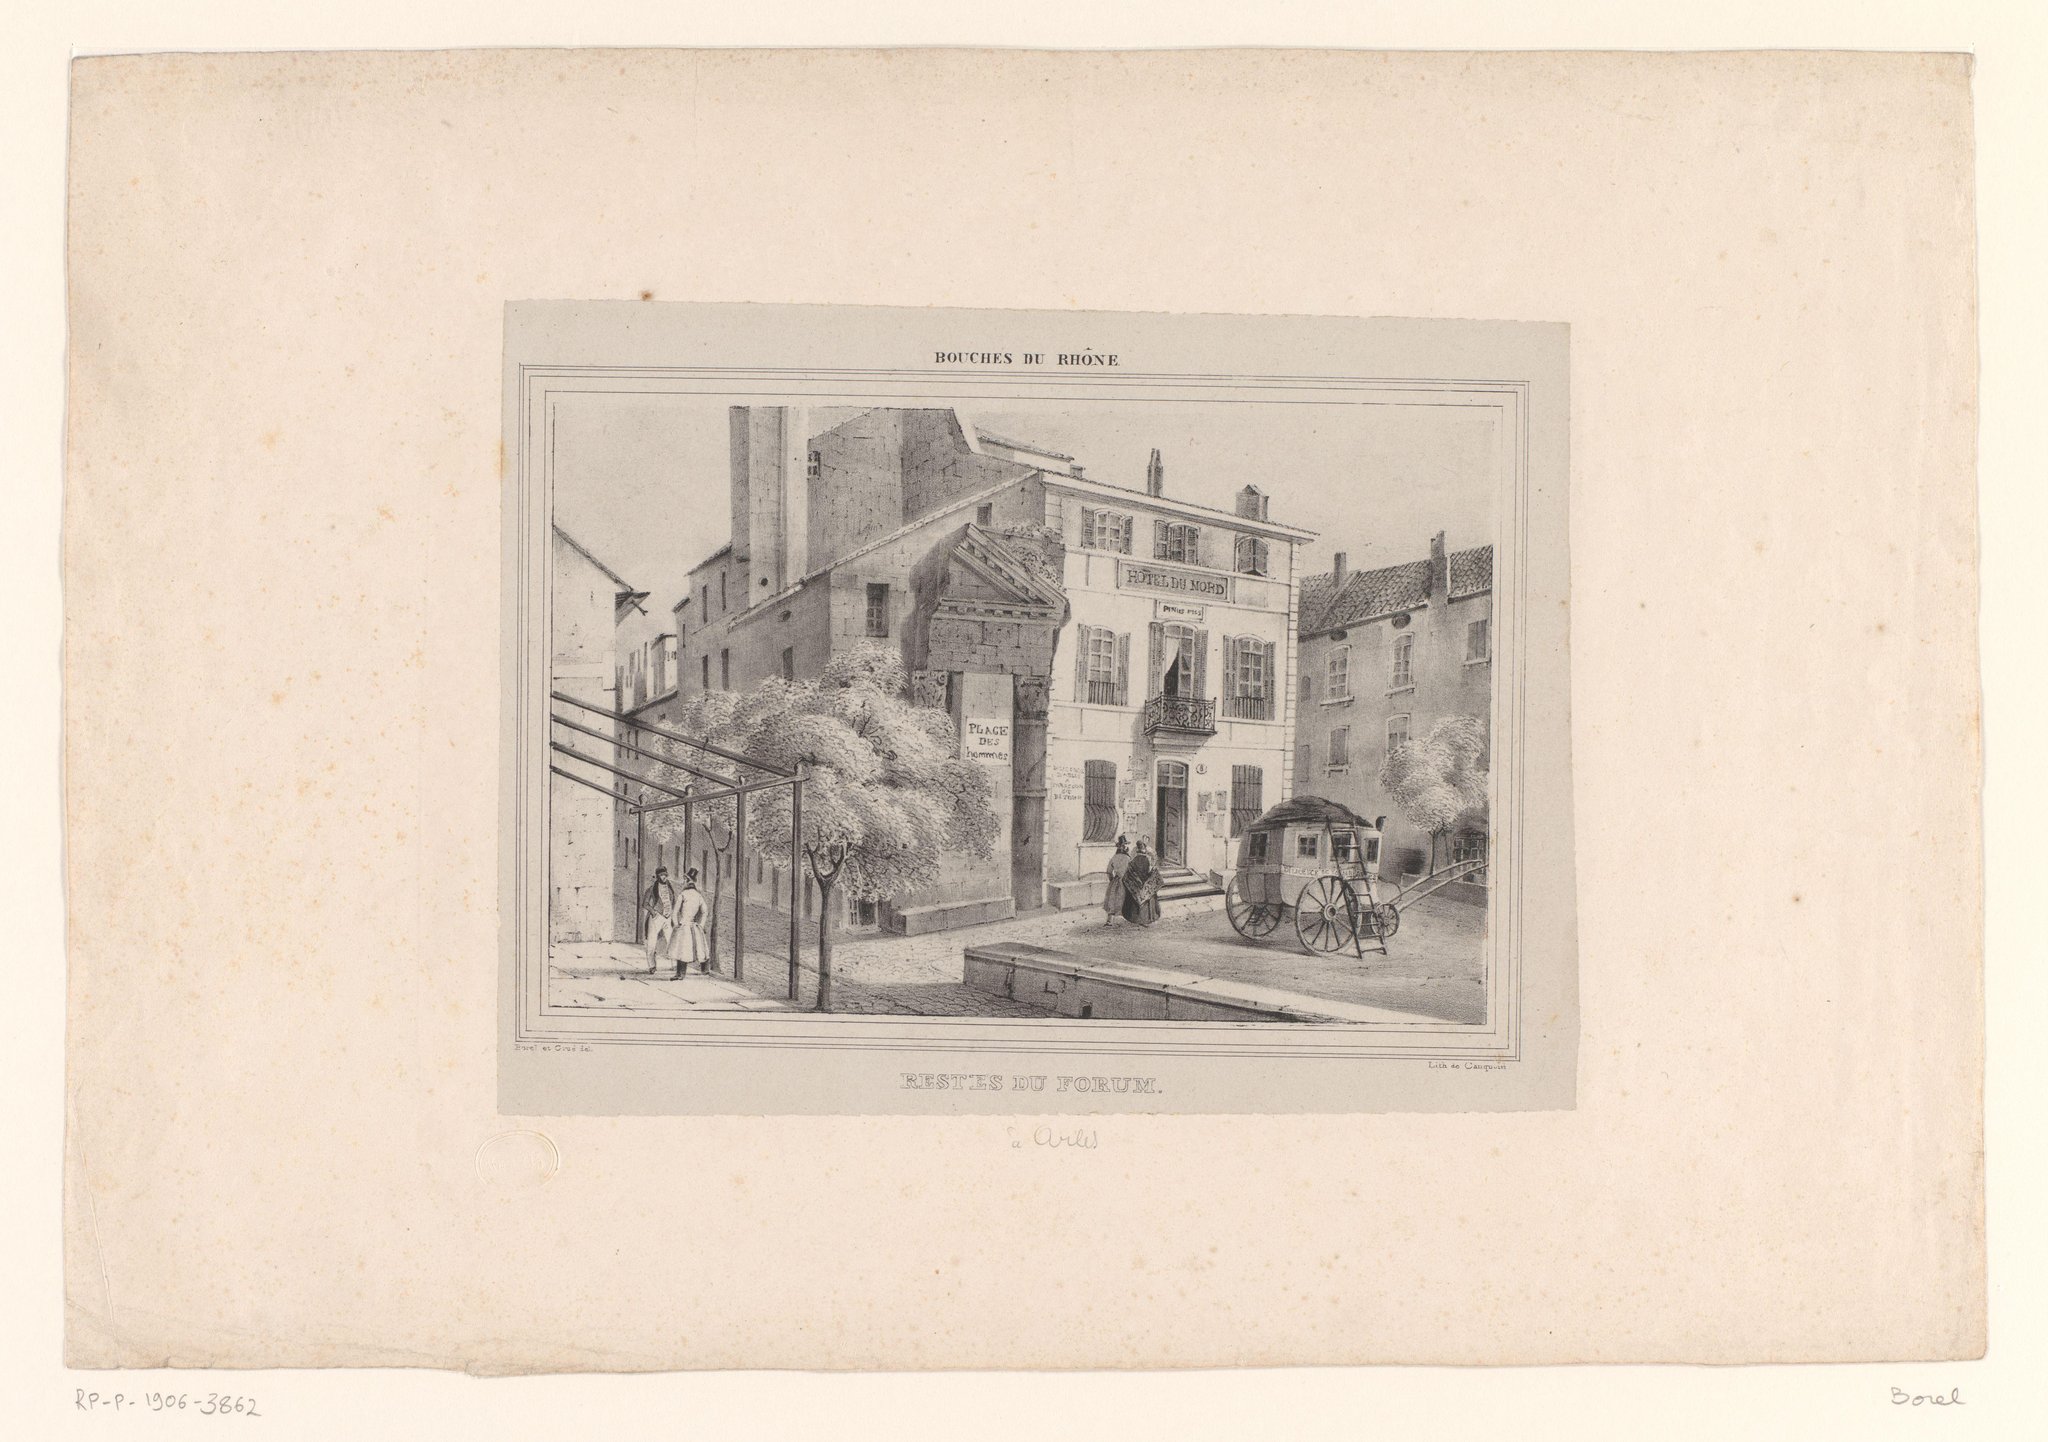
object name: print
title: Langs de oevers van de Rhône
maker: canquoin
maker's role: lithograaf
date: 1832-1833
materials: paper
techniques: lithograph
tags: ruin of a building ~ architecture, village square, place (+ city(-scape) with figures, staffage)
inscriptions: collector's mark: Lugt 2228a, check stamp: ‘BG’